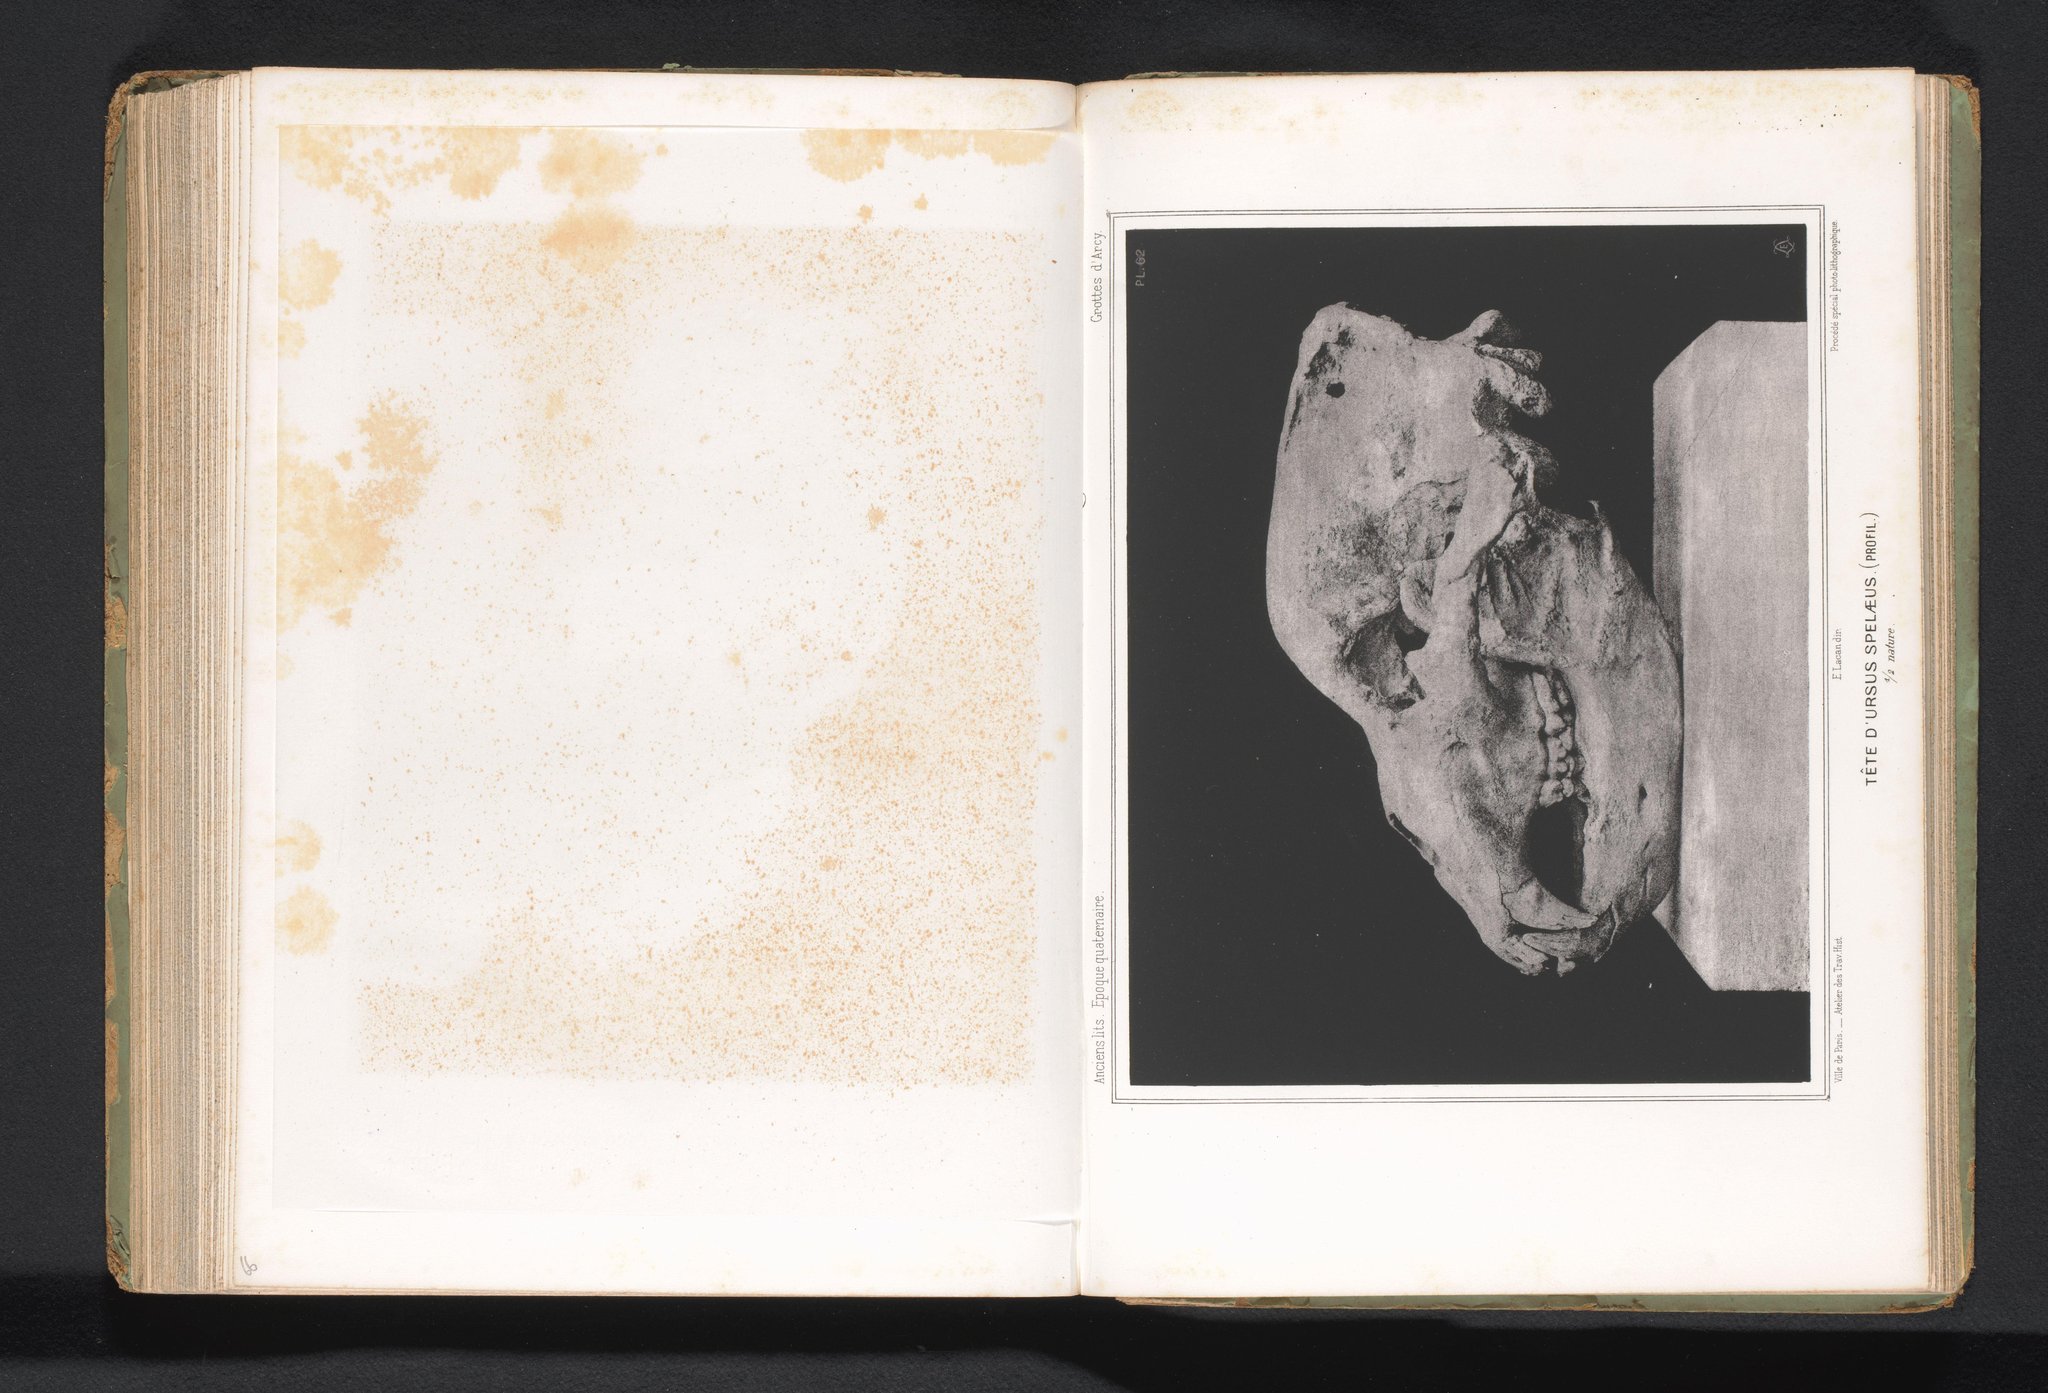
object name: page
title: Schedel van een holenbeer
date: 1864-1869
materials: paper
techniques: photolithography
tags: mammals (+ skeleton of an animal)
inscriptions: inscription: ‘PL.62’, inscription: ‘1/2 nature’, inscription: ‘Procédé spécial photo-lithographique’, monogram: ‘EL’